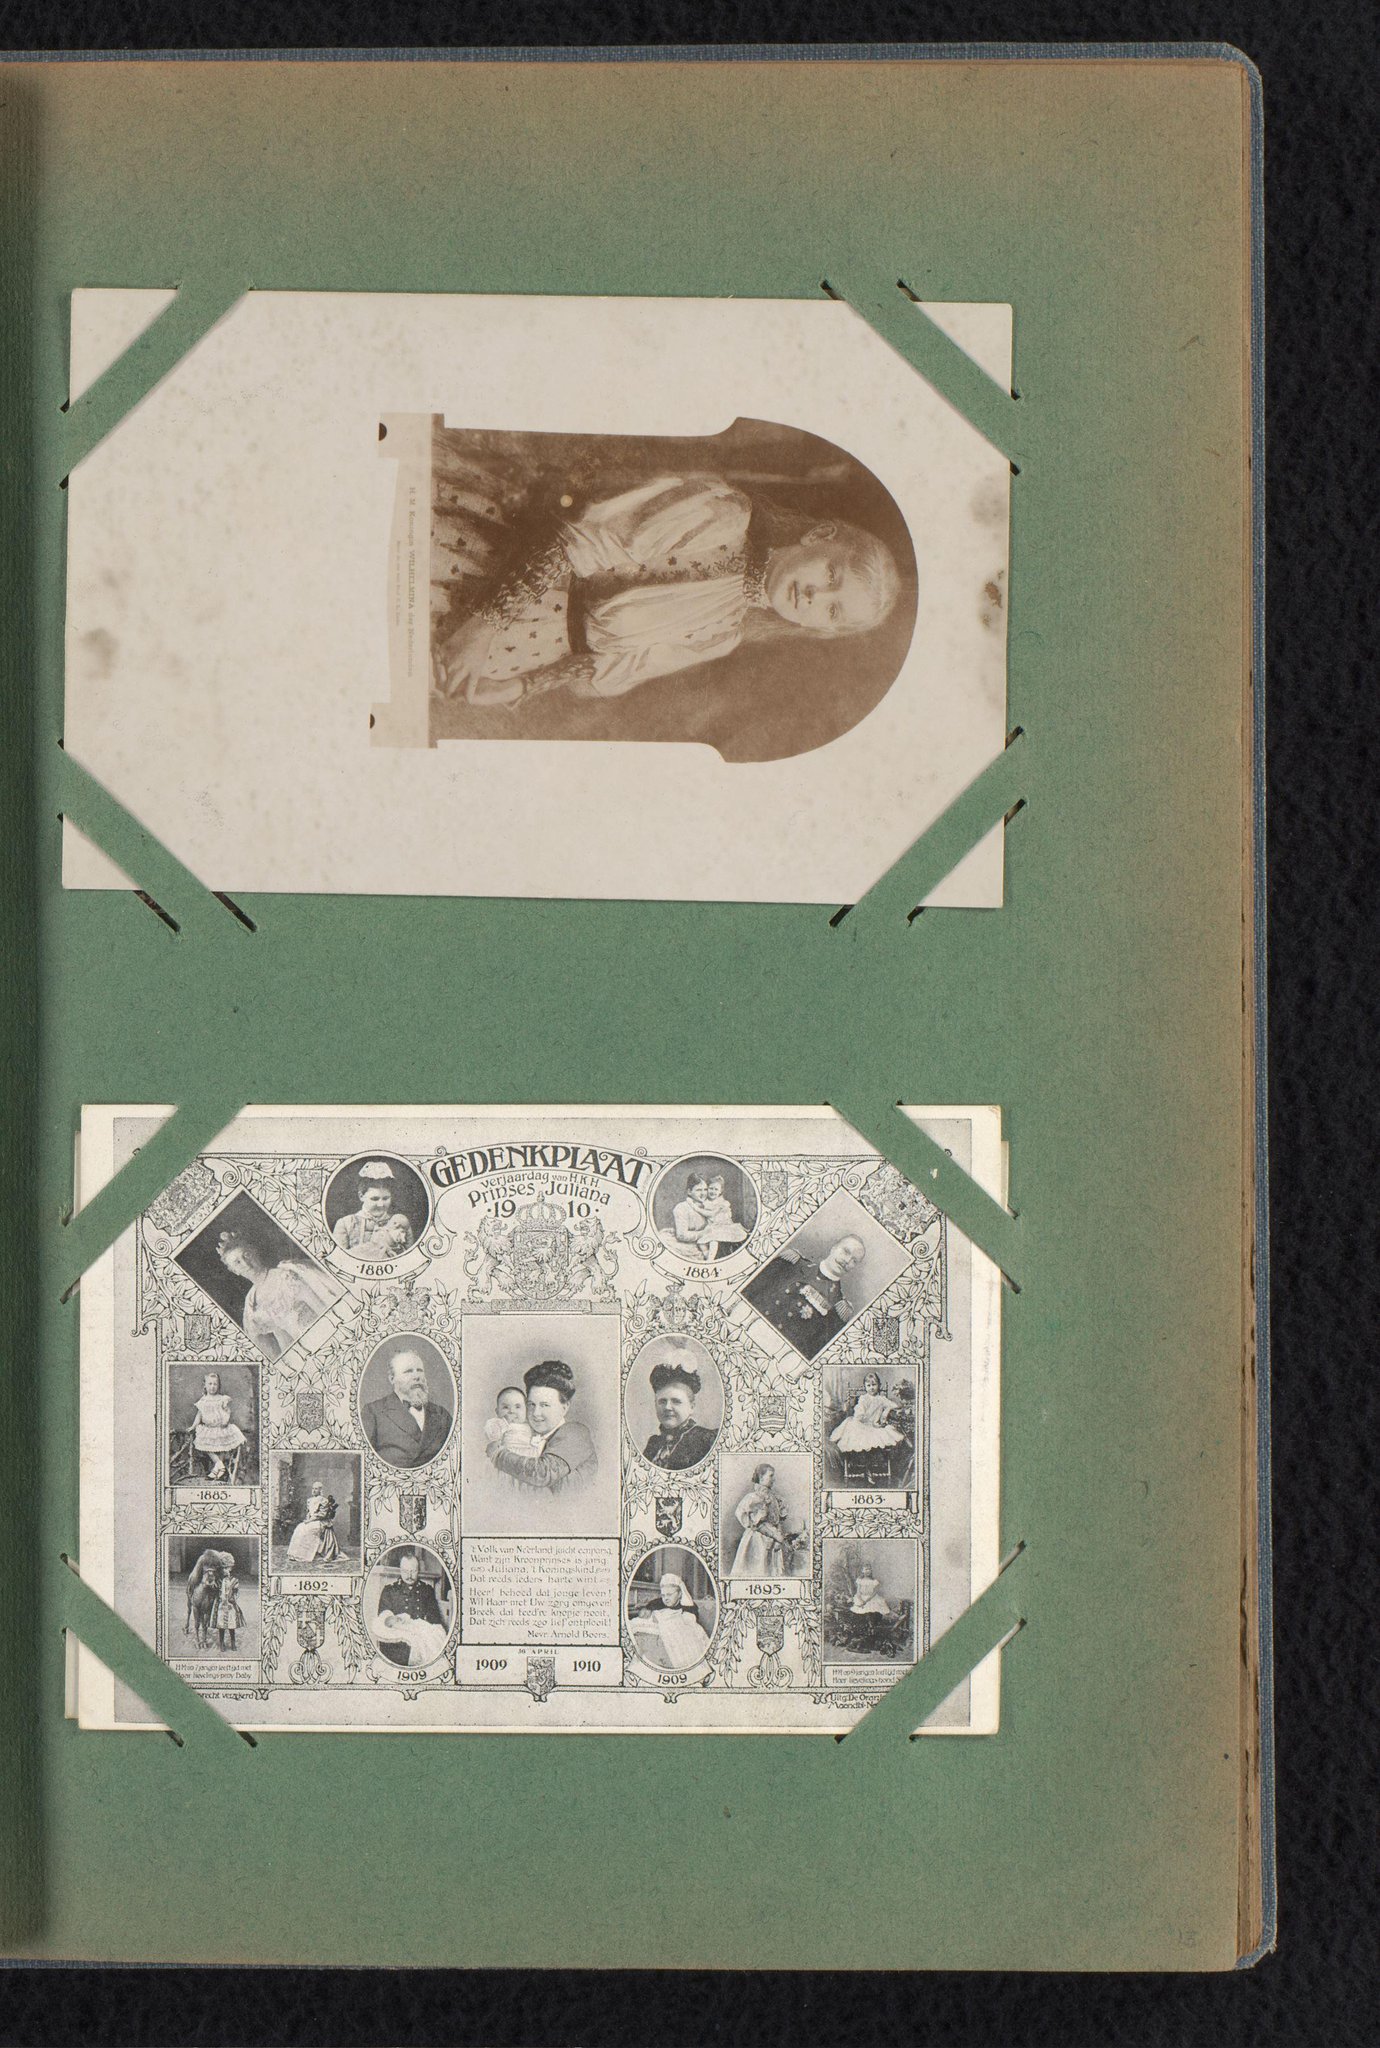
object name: reproduction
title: Fotoreproductie van een ets van Wilhelmina door Carel Lodewijk Dake en een prentbriefkaart met een stamboom ter gelegenheid van de verjaardag van prinses Juliana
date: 1885-1910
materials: paper, cardboard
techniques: autotype, collodion silver print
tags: print maker, wilhelmina of the netherlands, the hague, juliana of the netherlands, queen, family lineage, pedigree, genealogical tree or table, girl (child between toddler and youth)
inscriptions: inscription: ‘H.M. Koningin Wilhelmina der Nederlanden./ Naar de ets van Prof. C.L. Dake.’, inscription: ‘Gedenkplaat/ verjaardag van H.K.H./ Prinses Juliana/ 1910’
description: Deze foto en prent maken deel uit van een album.